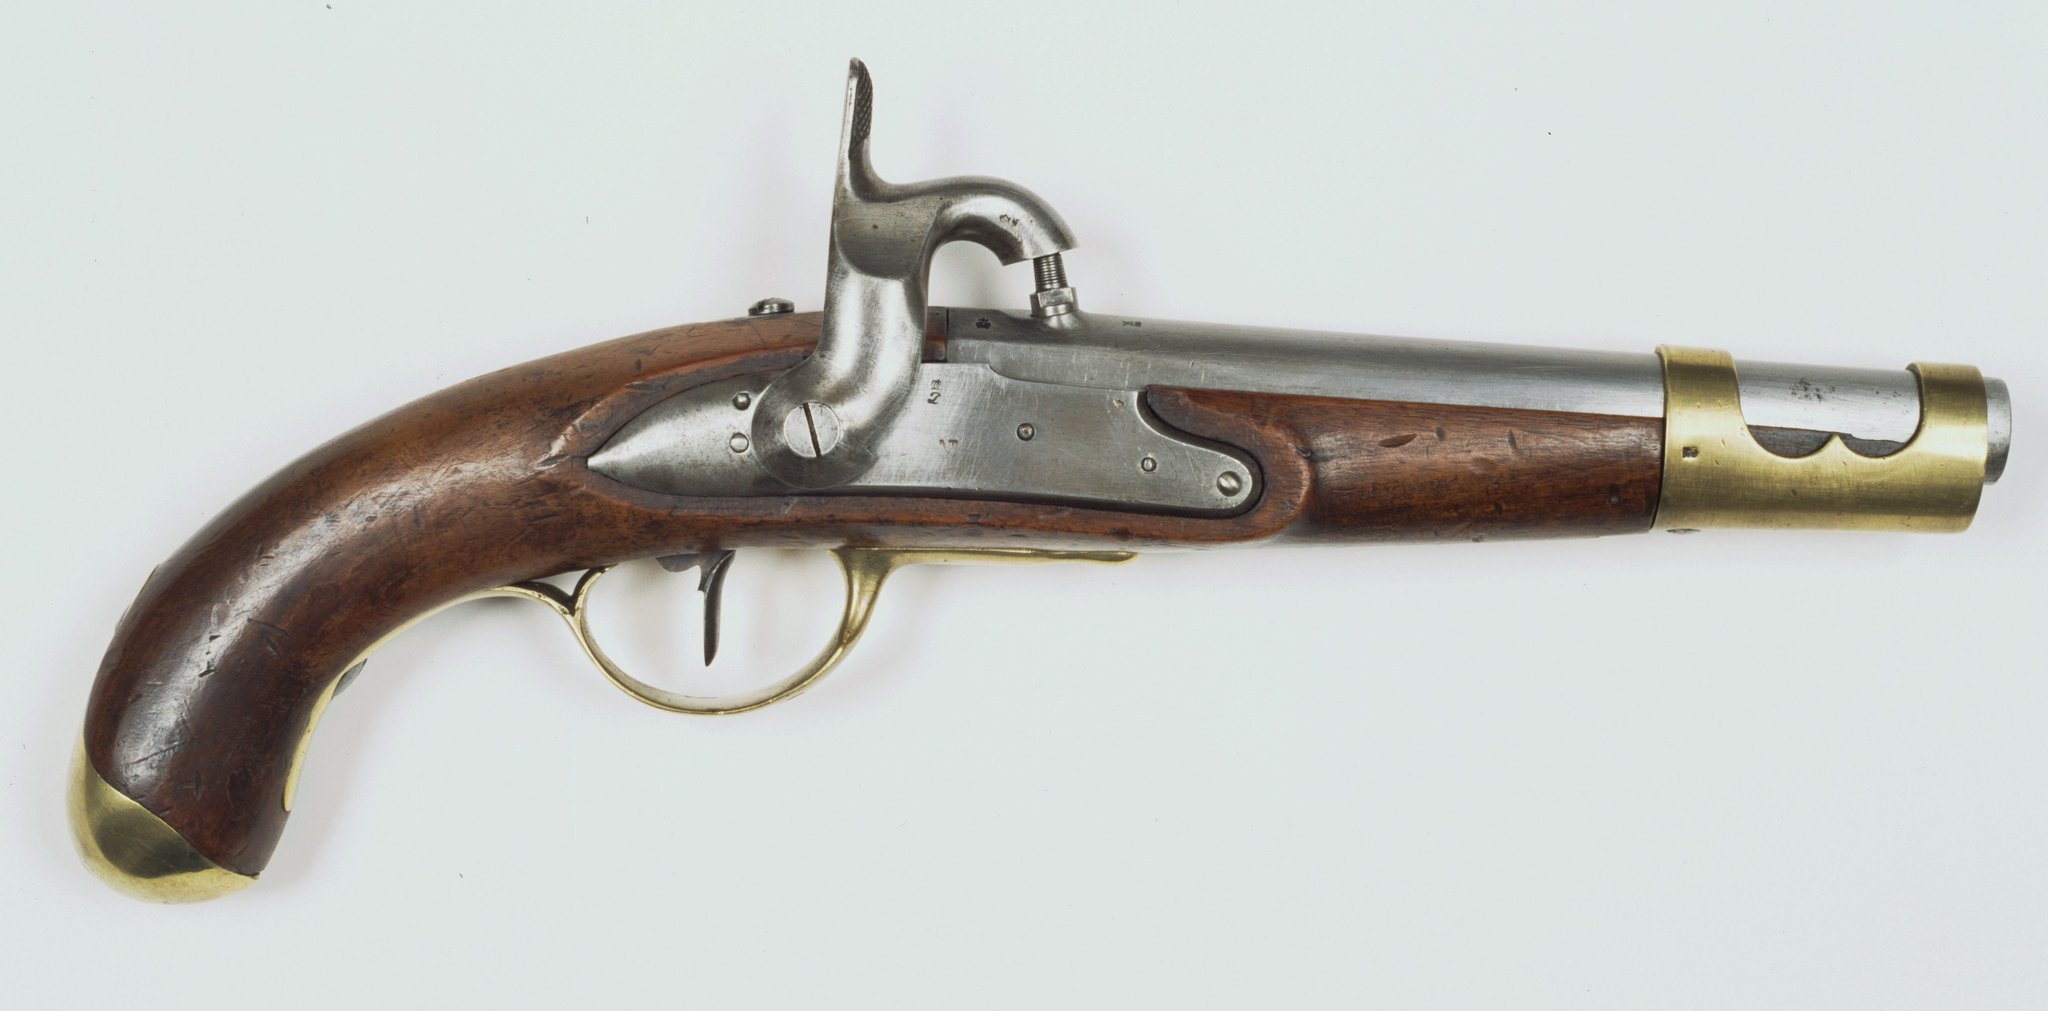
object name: percussion pistol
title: Percussie legerpistool model M 1815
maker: Anonymous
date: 1815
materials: brass, iron, wood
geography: netherlands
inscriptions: signature: ‘D met kroon’, signature: ‘P met kroon’, signature: ‘JY’, signature: ‘IS met kroon’, signature: ‘K met kroon’, signature: ‘T met kroon’